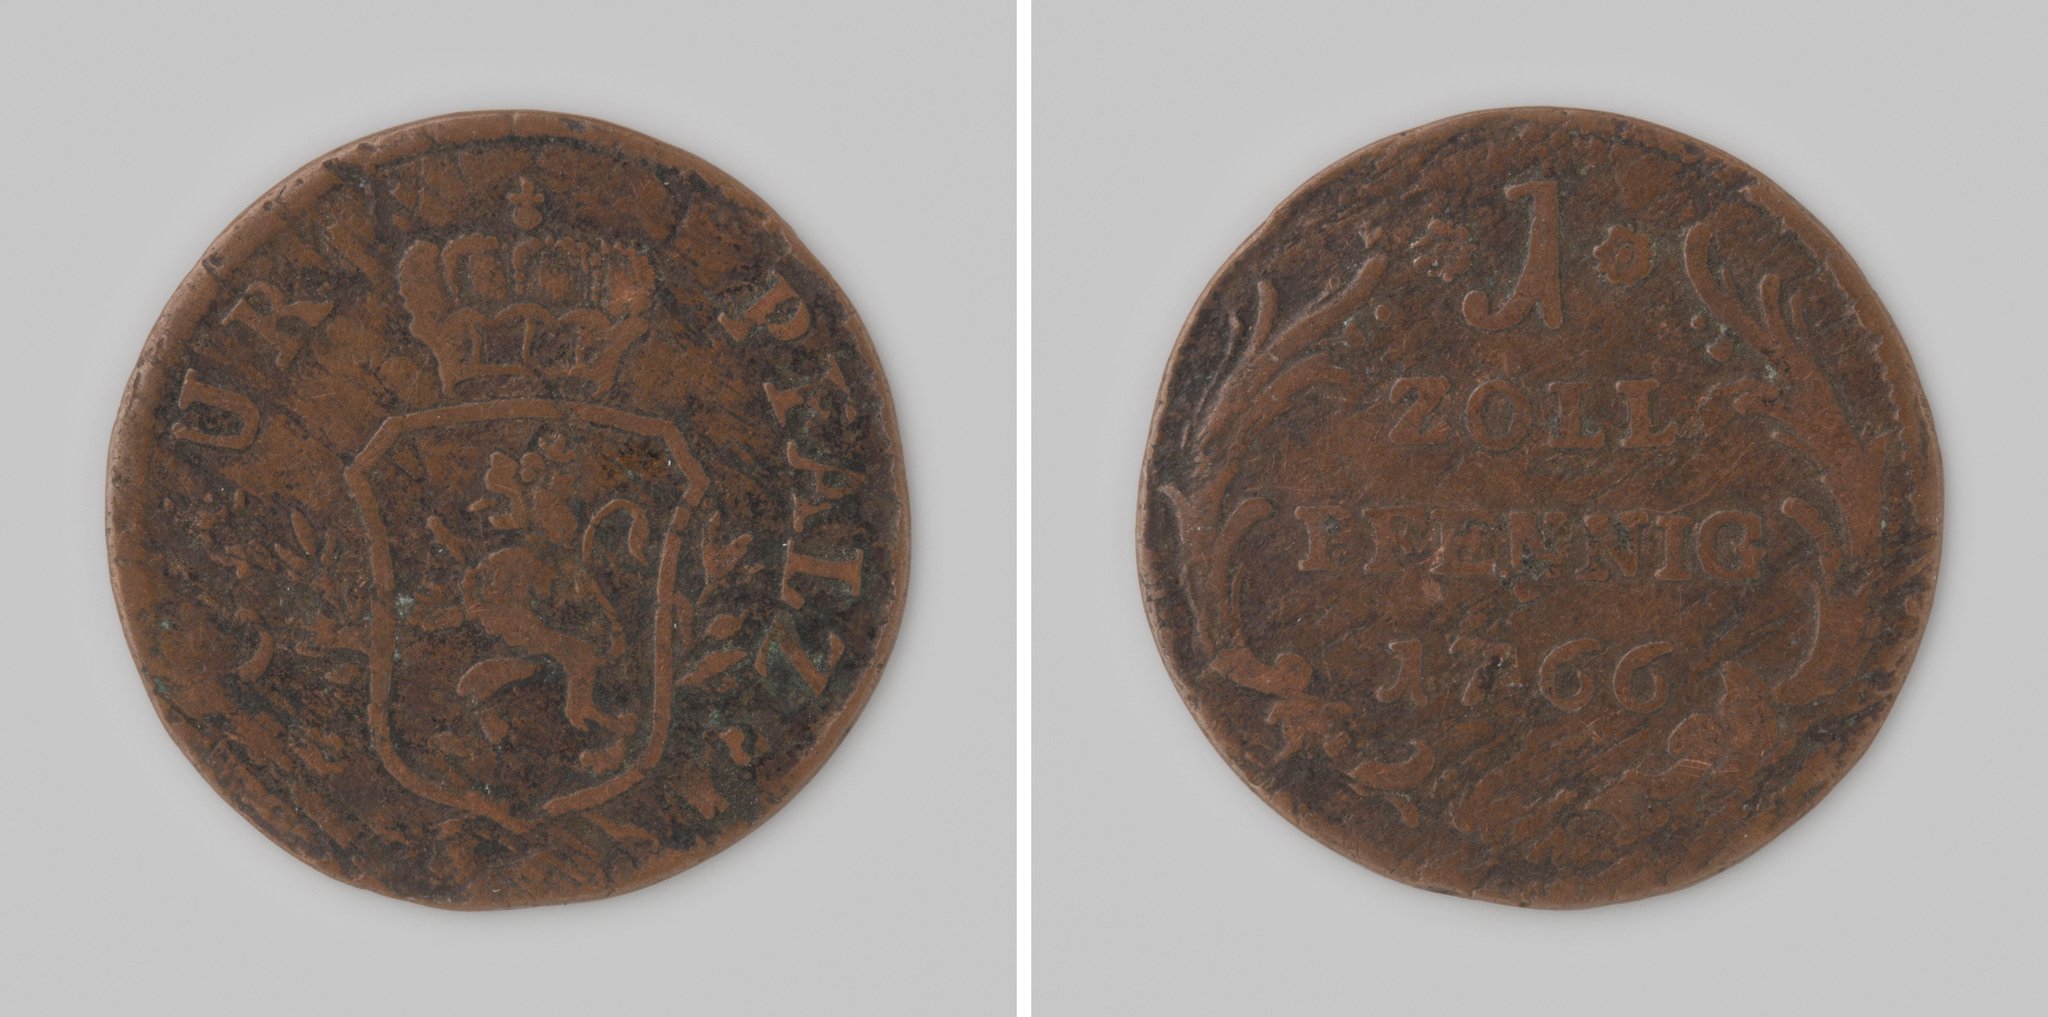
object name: coin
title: Zollpfennig uit de Kurpfalz in Duitsland, 1766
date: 1766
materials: copper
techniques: striking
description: Koperen munt. Voorzijde: tussen twee twee takken gekroond wapenschild. Omschrift: Chur Pfalz. Keerzijde: binnen barok-versiering in drie regels waarde-aanduiding: 1 Zoll Pfennig. Daaronder jaartal.